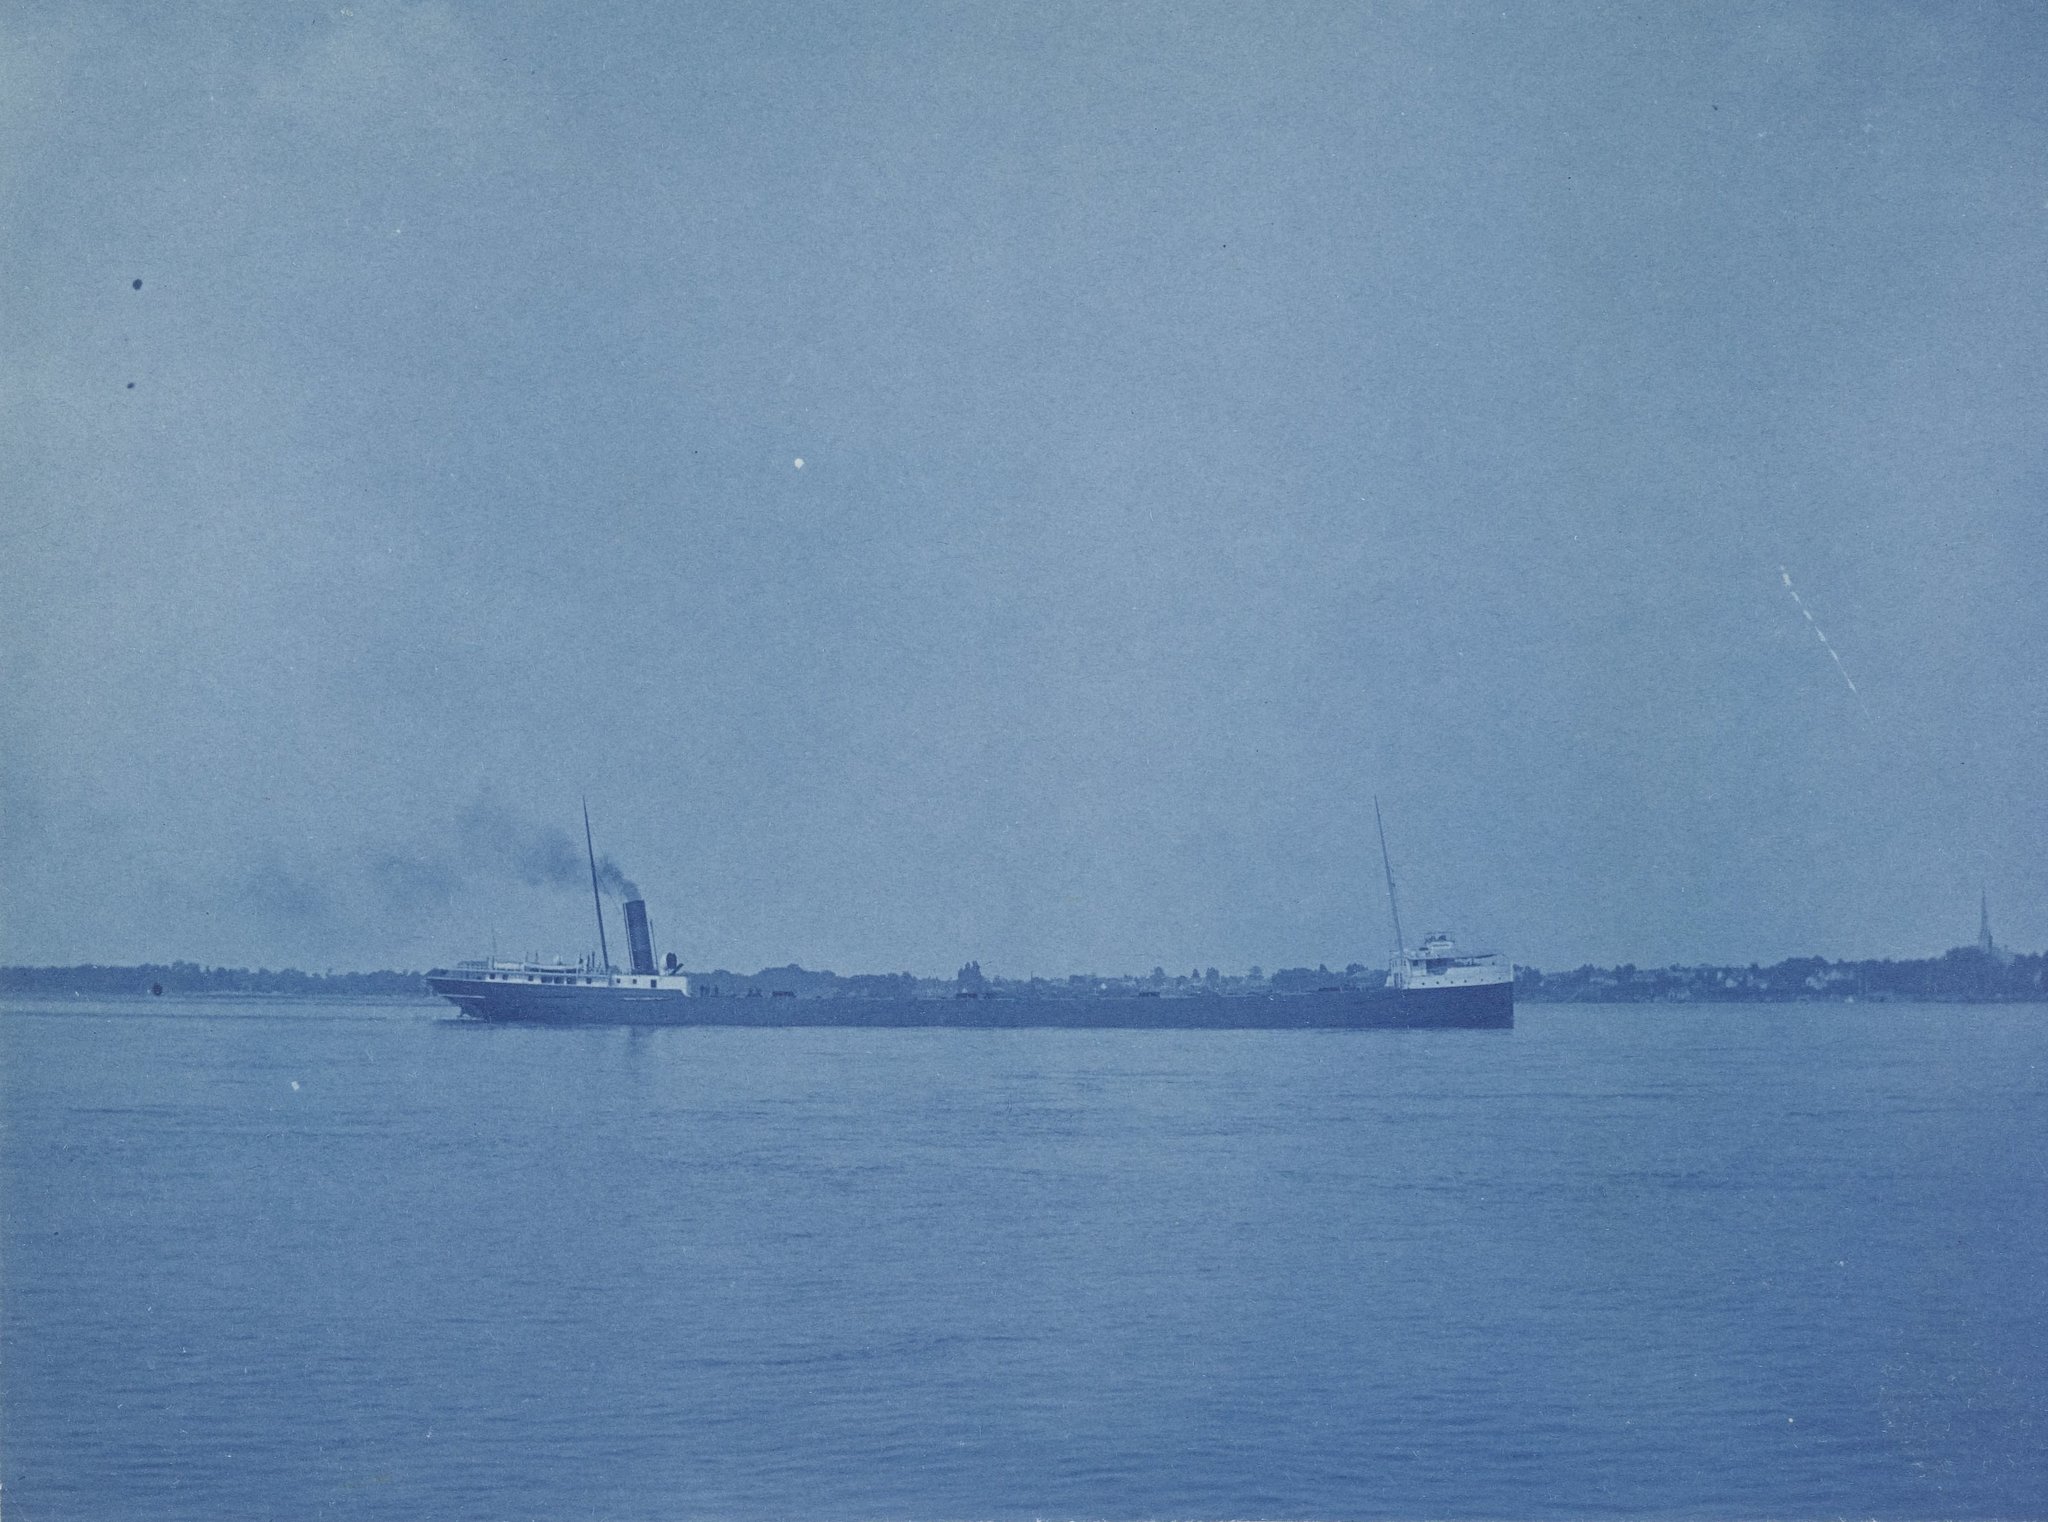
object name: photograph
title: Vrachtschip, Port Huron, Michigan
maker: Anonymous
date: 1890-1910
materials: paper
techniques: cyanotype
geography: port huron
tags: ships (in general)